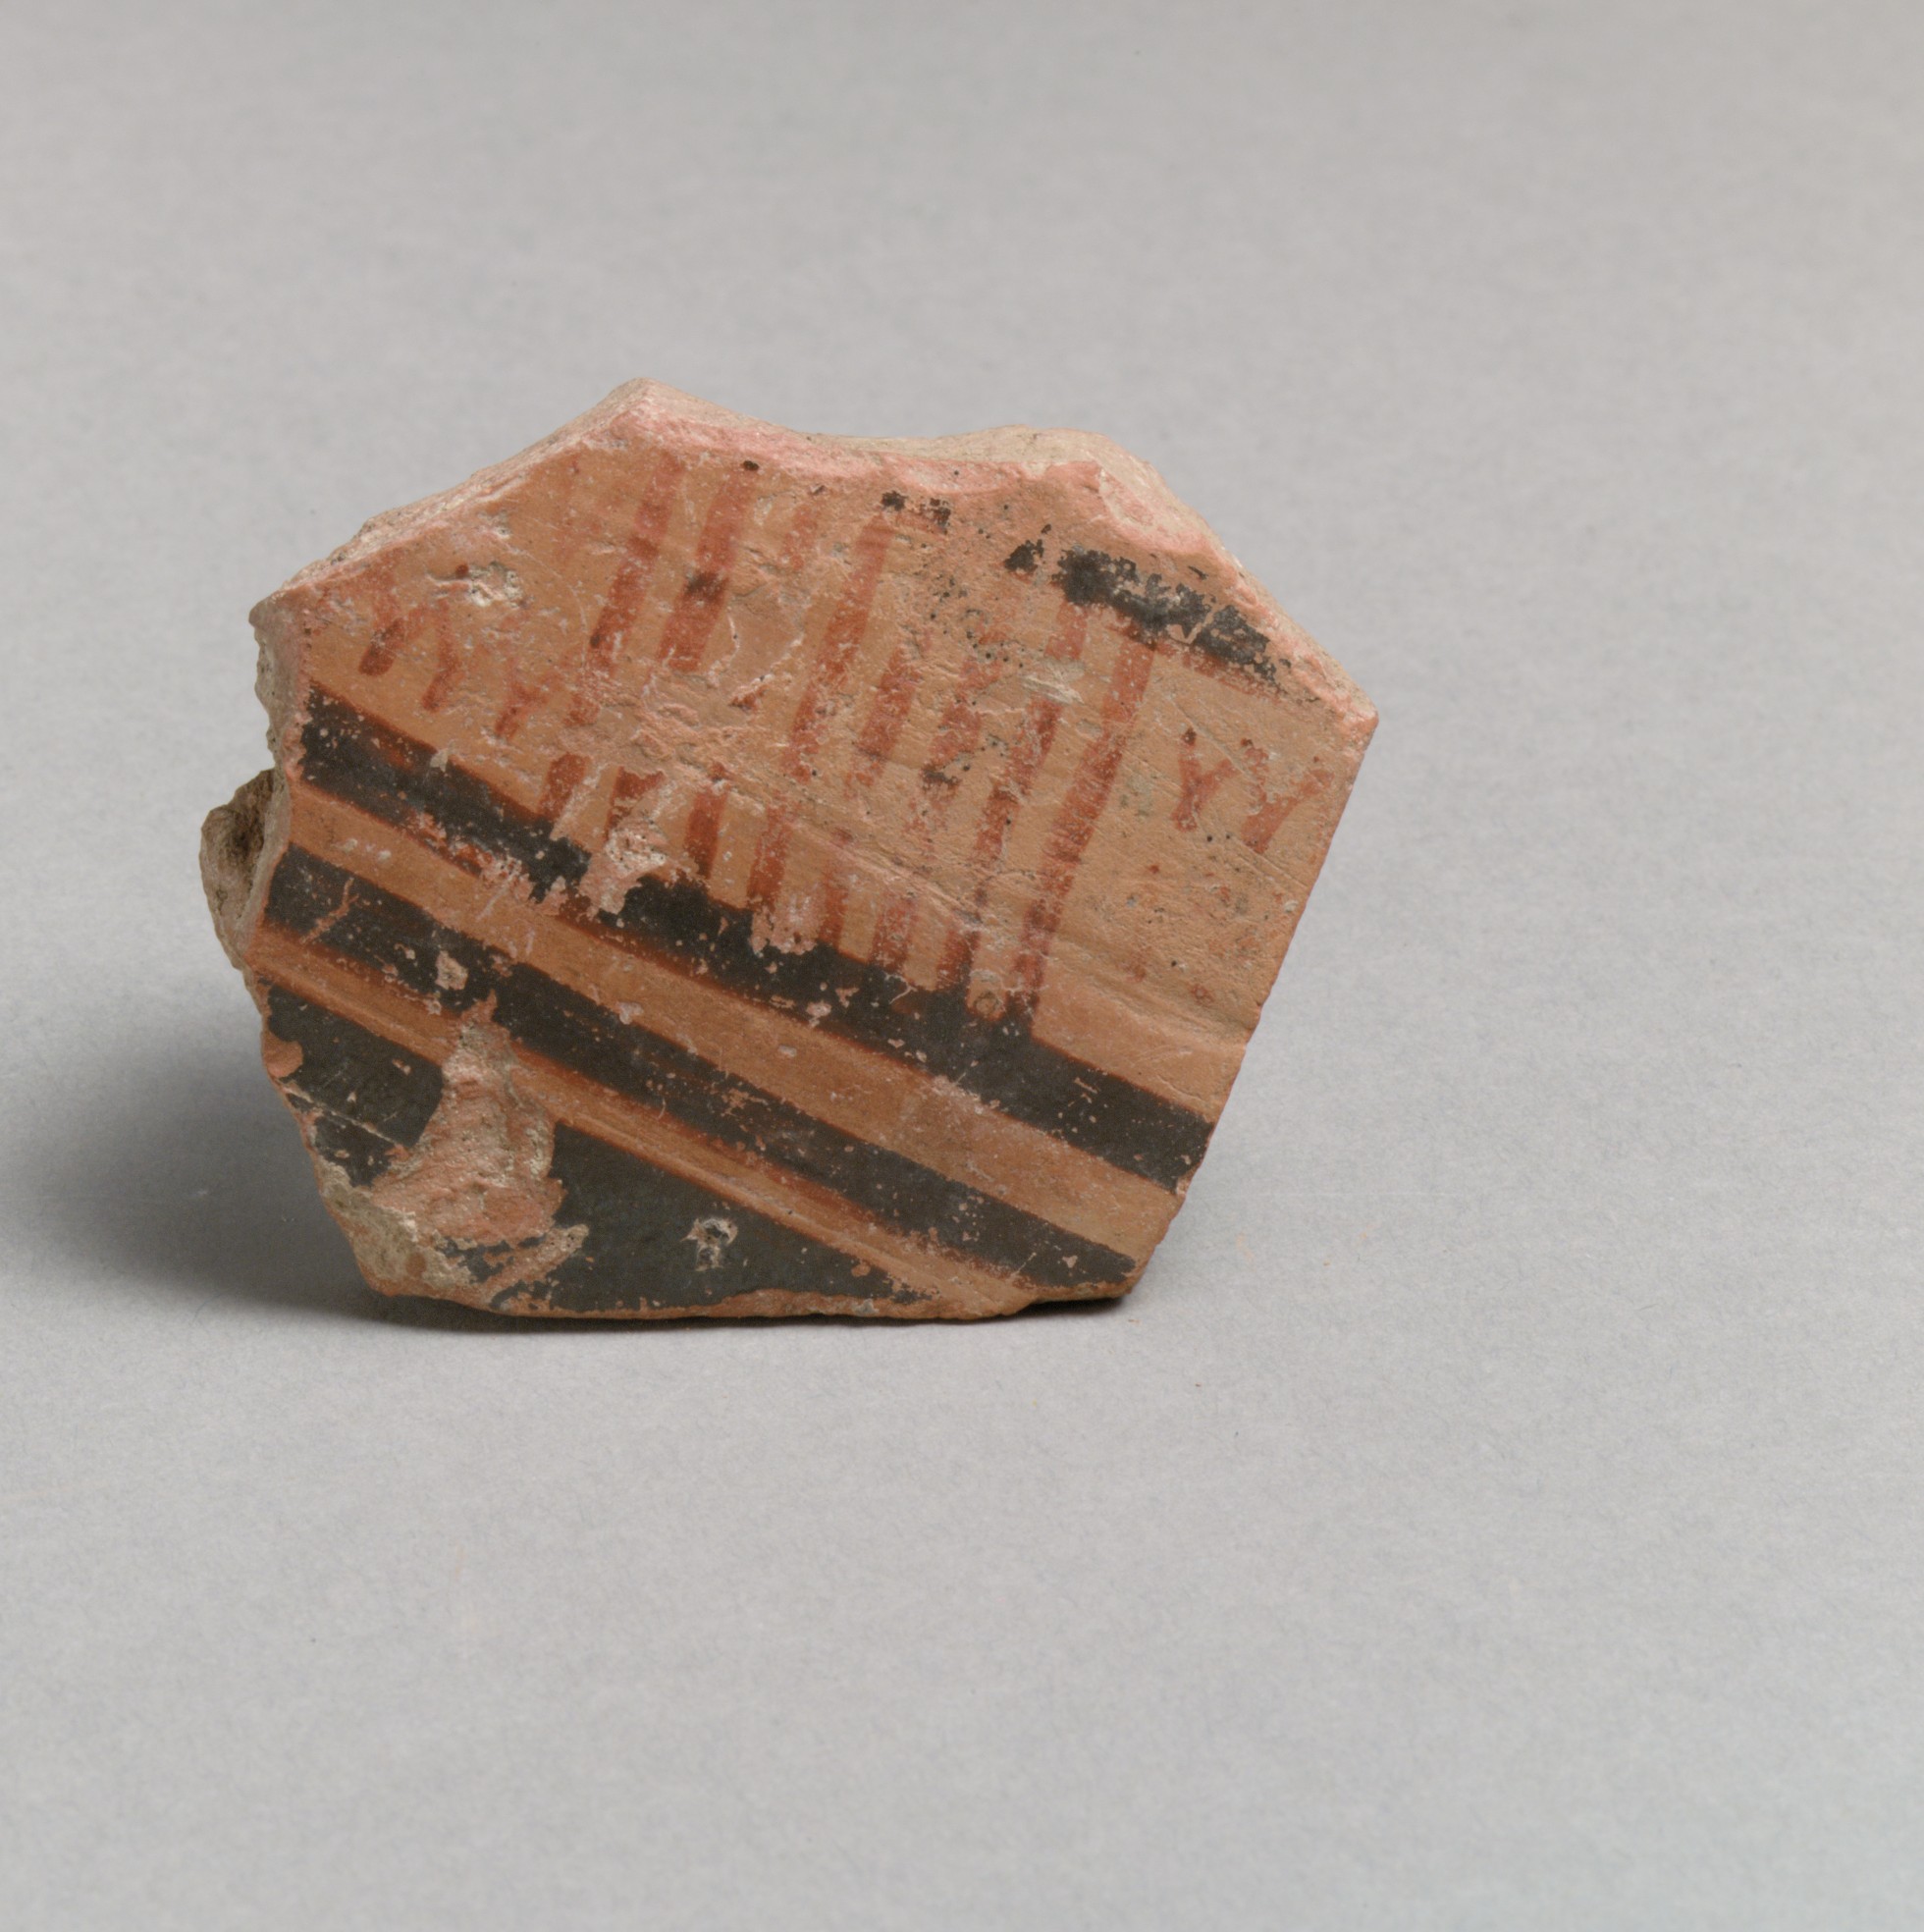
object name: vase fragment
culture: greek, laconian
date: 2000-1550 BCE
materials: terracotta